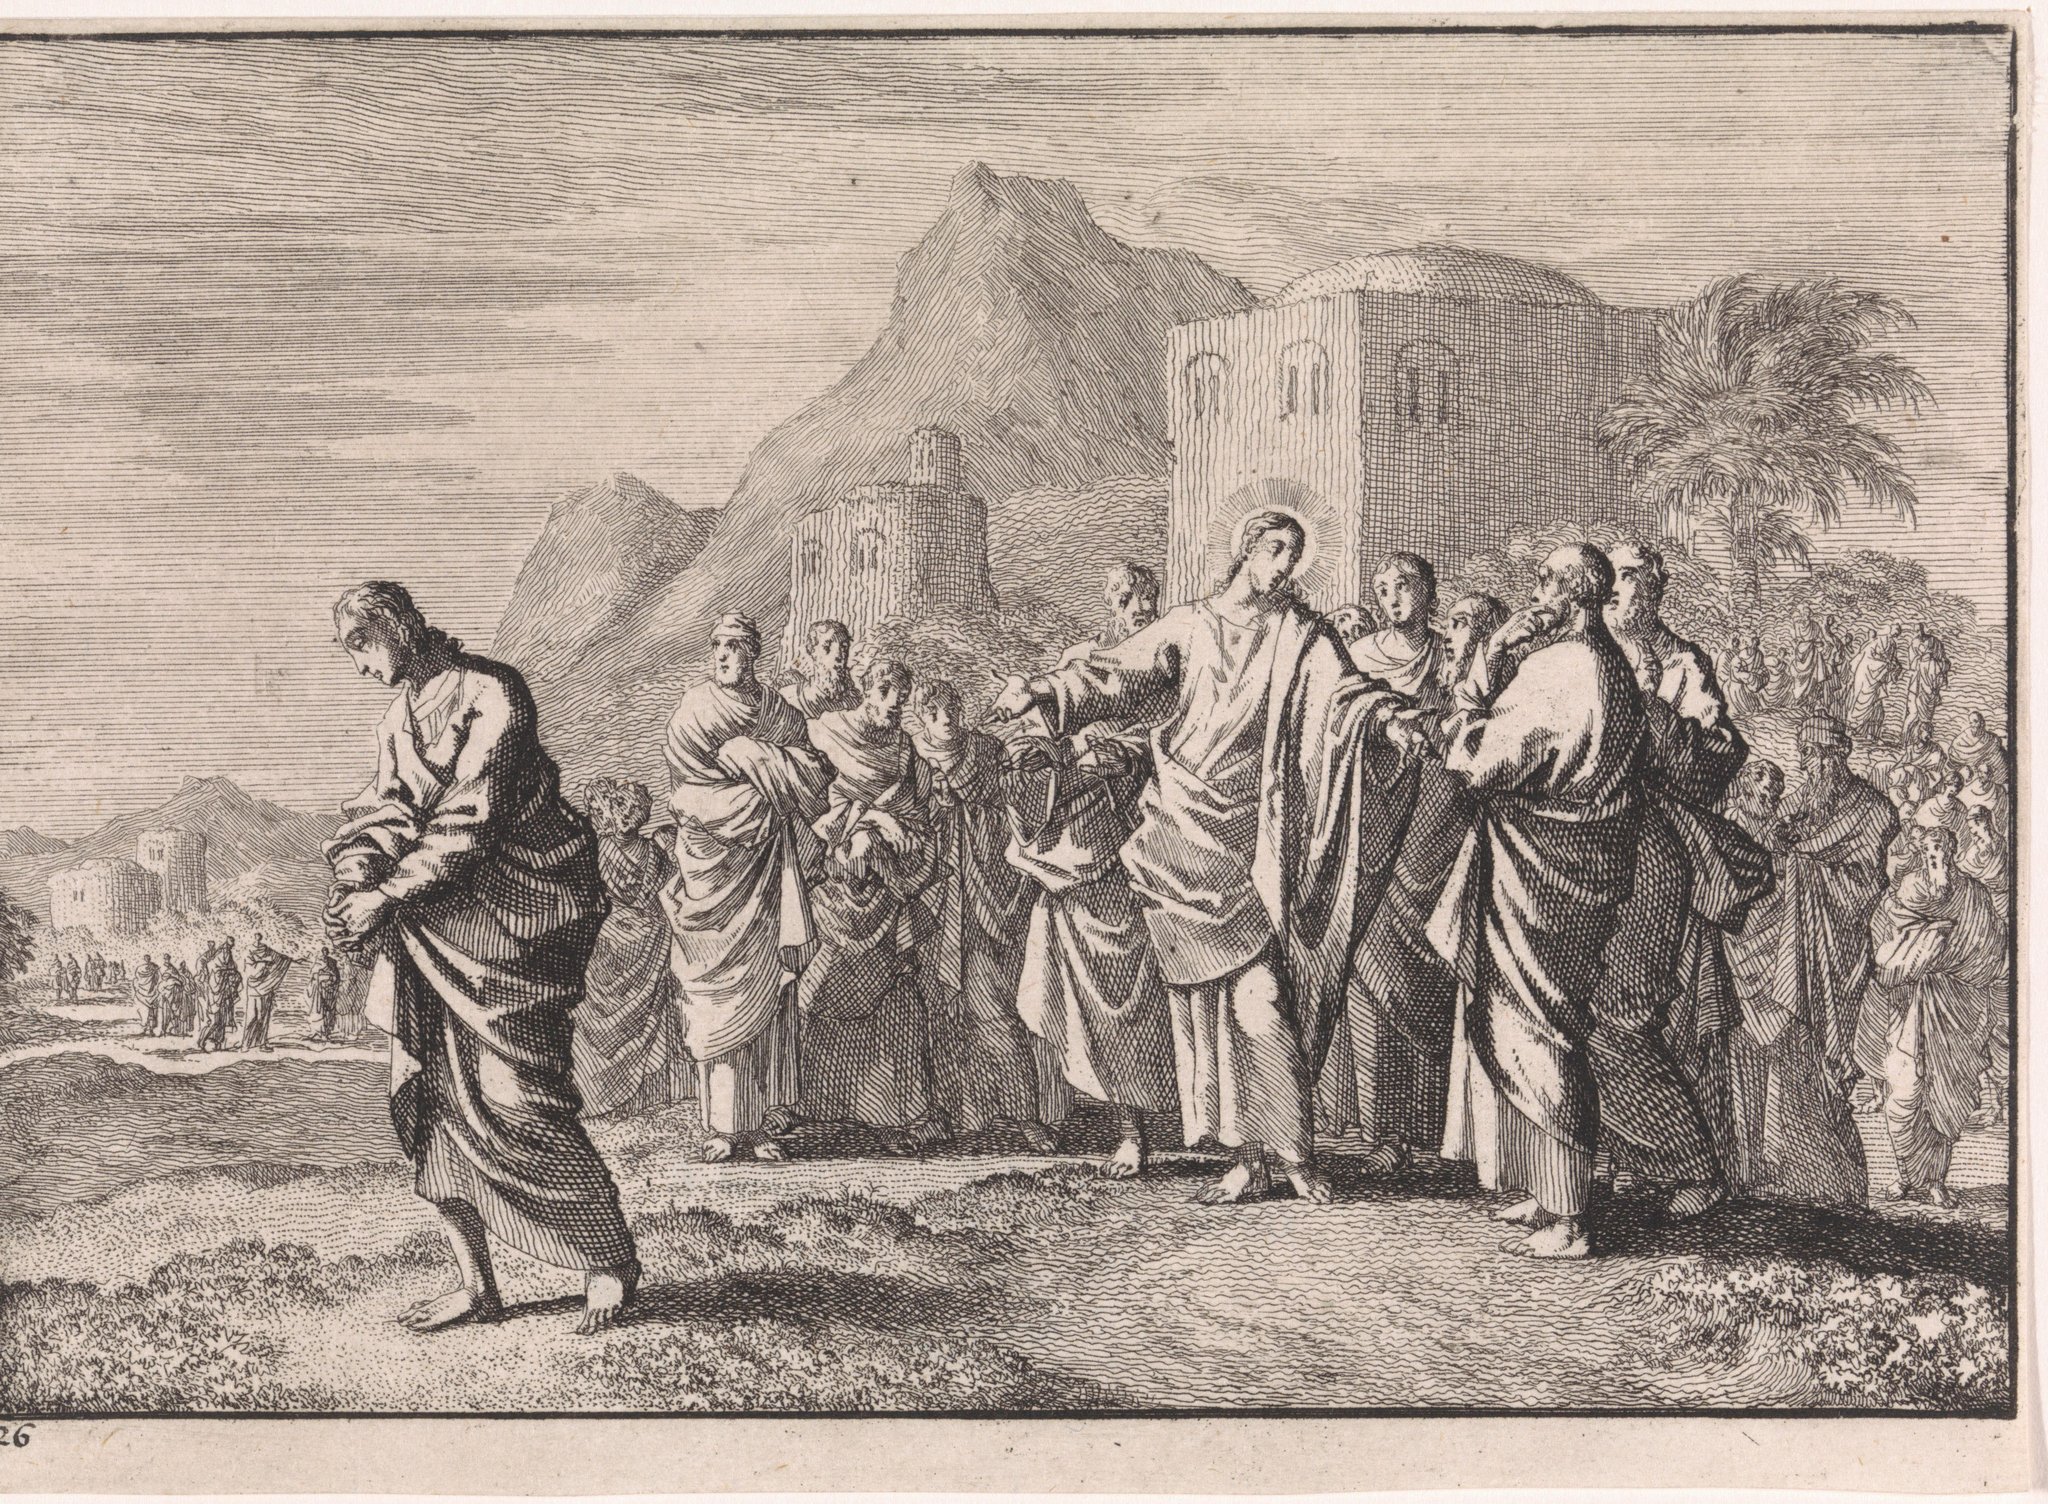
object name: print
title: Christus geeft raad aan een rijke jongeling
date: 1703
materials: paper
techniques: etching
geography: amsterdam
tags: a rich young man who came to see christ goes away sorrowful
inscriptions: collector's mark: Lugt 2228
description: Proefdruk van een boekillustratie voor David Martin. Historie des Ouden en Nieuwen Testaments. Amsterdam, Pieter Mortier, 1703. Deel II. De boekillustraties voor de Mortierbijbel hebben verschillende staten en kopieën, waarbij de chronologische volgorde moeilijk te achterhalen valt. Als boekillustraties werden ze bovendien herhaaldelijk opnieuw gebruikt voor andere boekwerken.